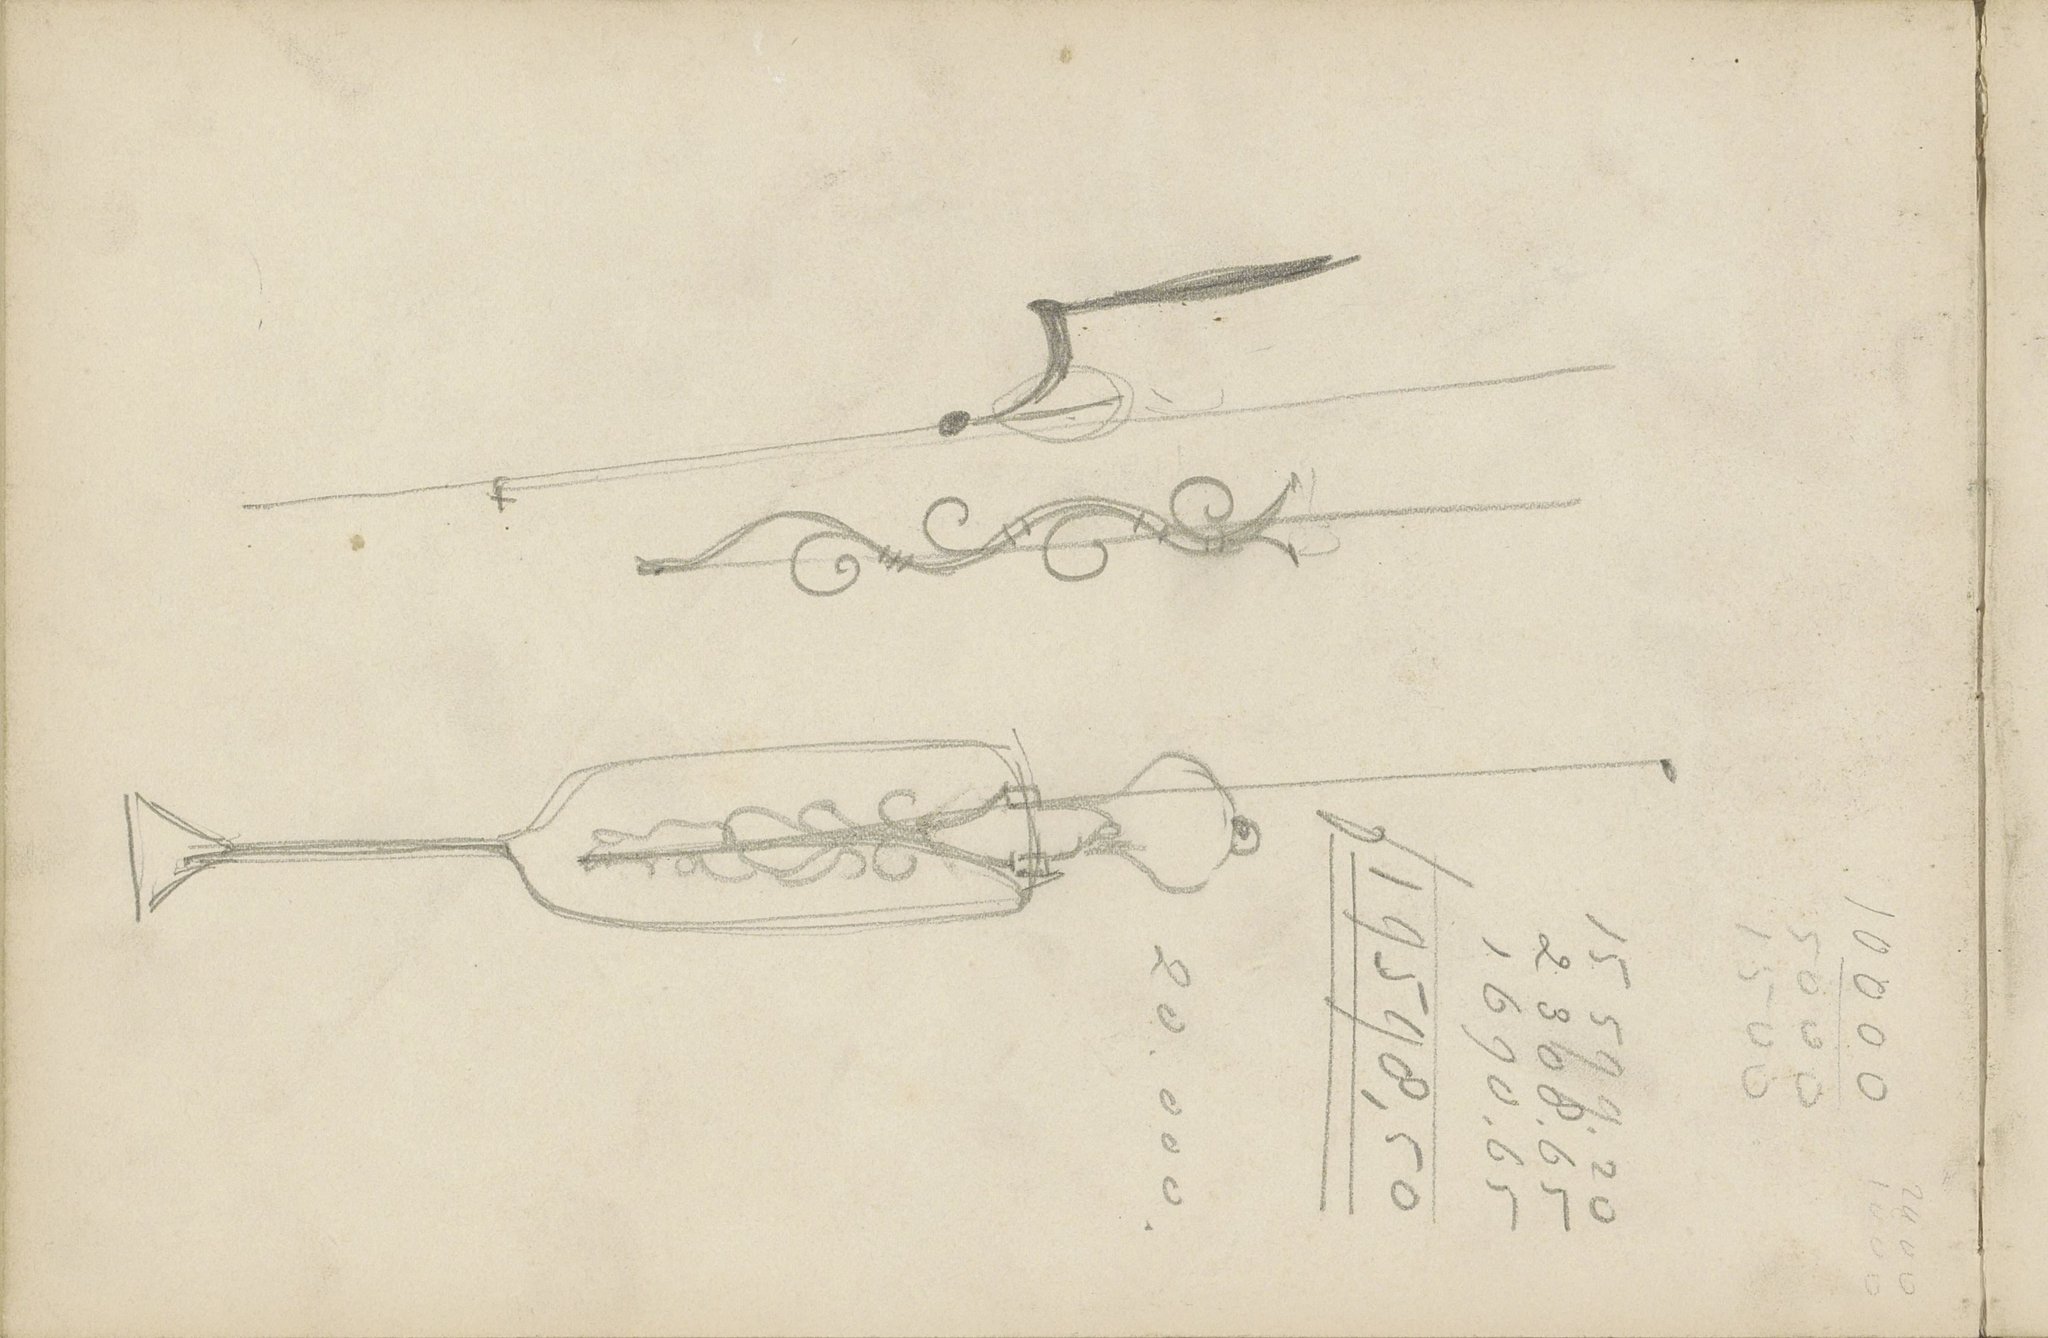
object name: sketchbook leaf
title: Studies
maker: carel adolph lion cachet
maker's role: draughtsman, print maker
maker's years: 1864-1945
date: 1908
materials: paper, pencil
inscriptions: annotation: ‘[...]’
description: Blad 17 verso uit een schetsboek met 25 bladen.